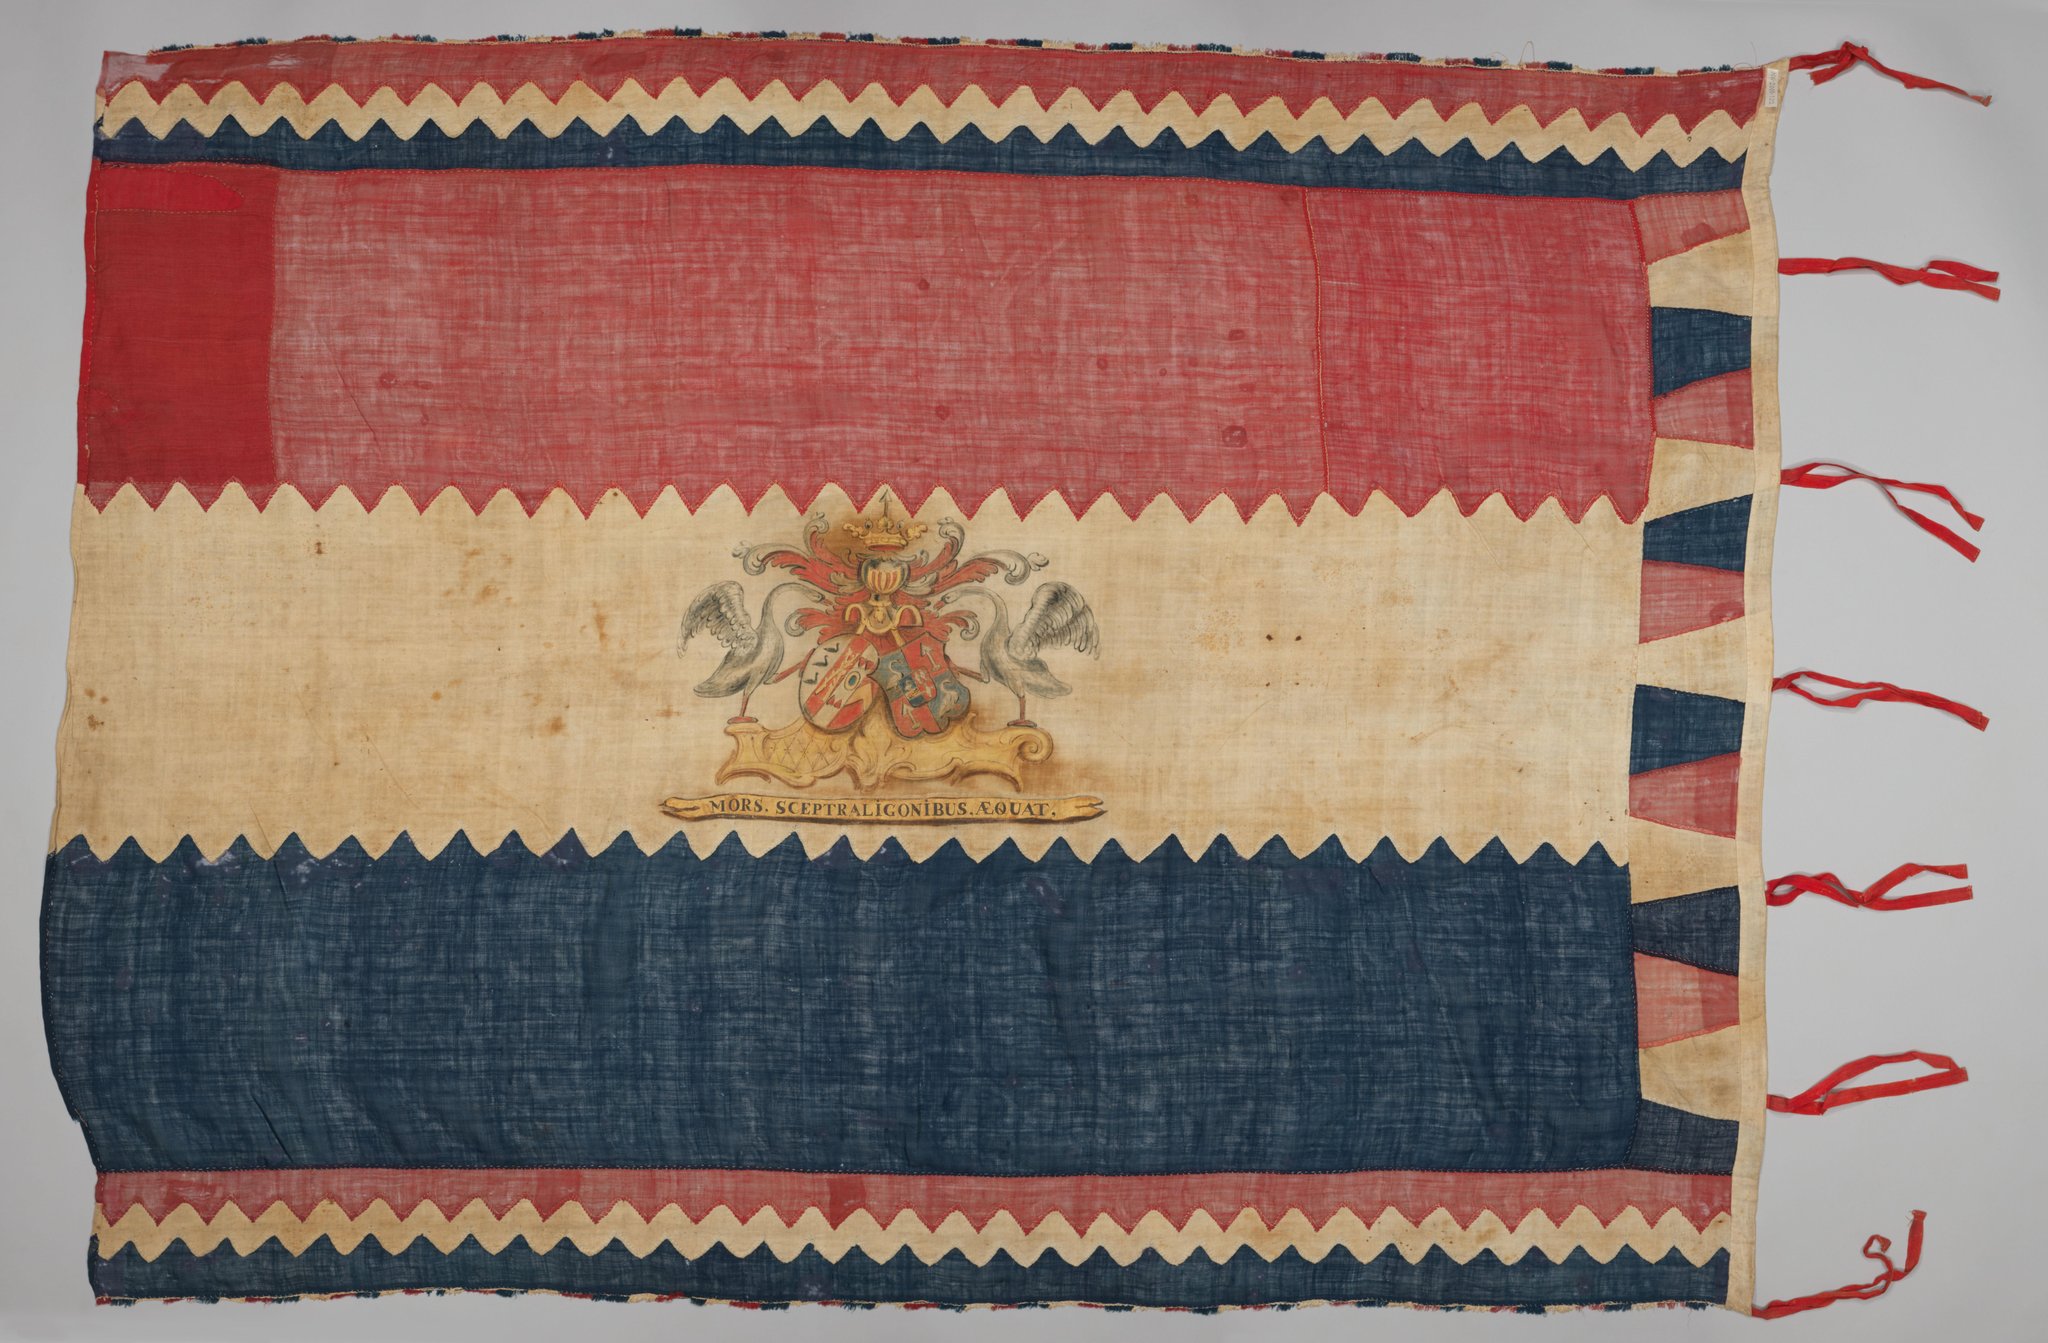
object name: flag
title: Wollen vlag: rood, wit en blauw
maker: Anonymous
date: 1767-1798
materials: linen, paint, wool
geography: netherlands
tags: armorial bearing, heraldry